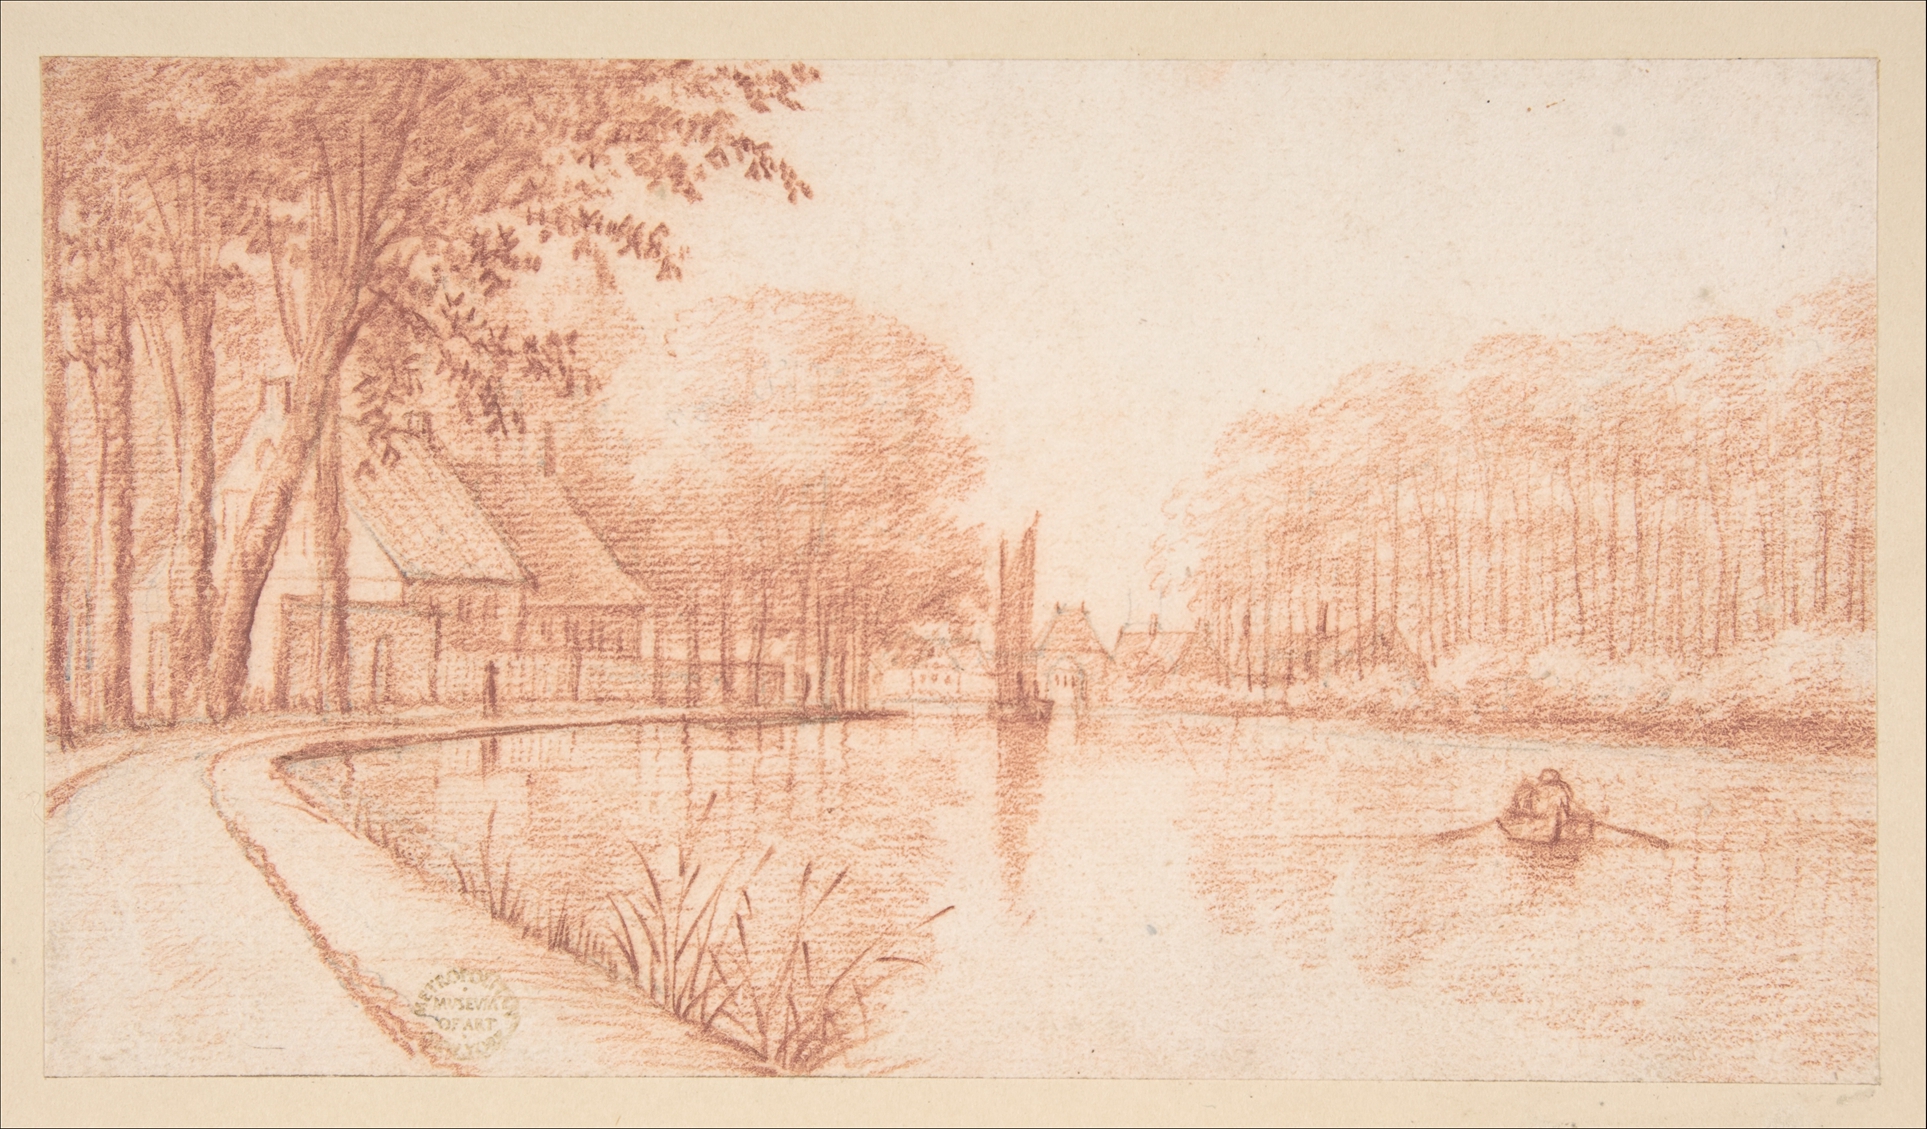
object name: drawing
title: River Scene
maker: abraham rutgers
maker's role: artist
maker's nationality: dutch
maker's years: 1632-1699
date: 1645-1699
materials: chalk, pencil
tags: houses,rivers,trees,boats